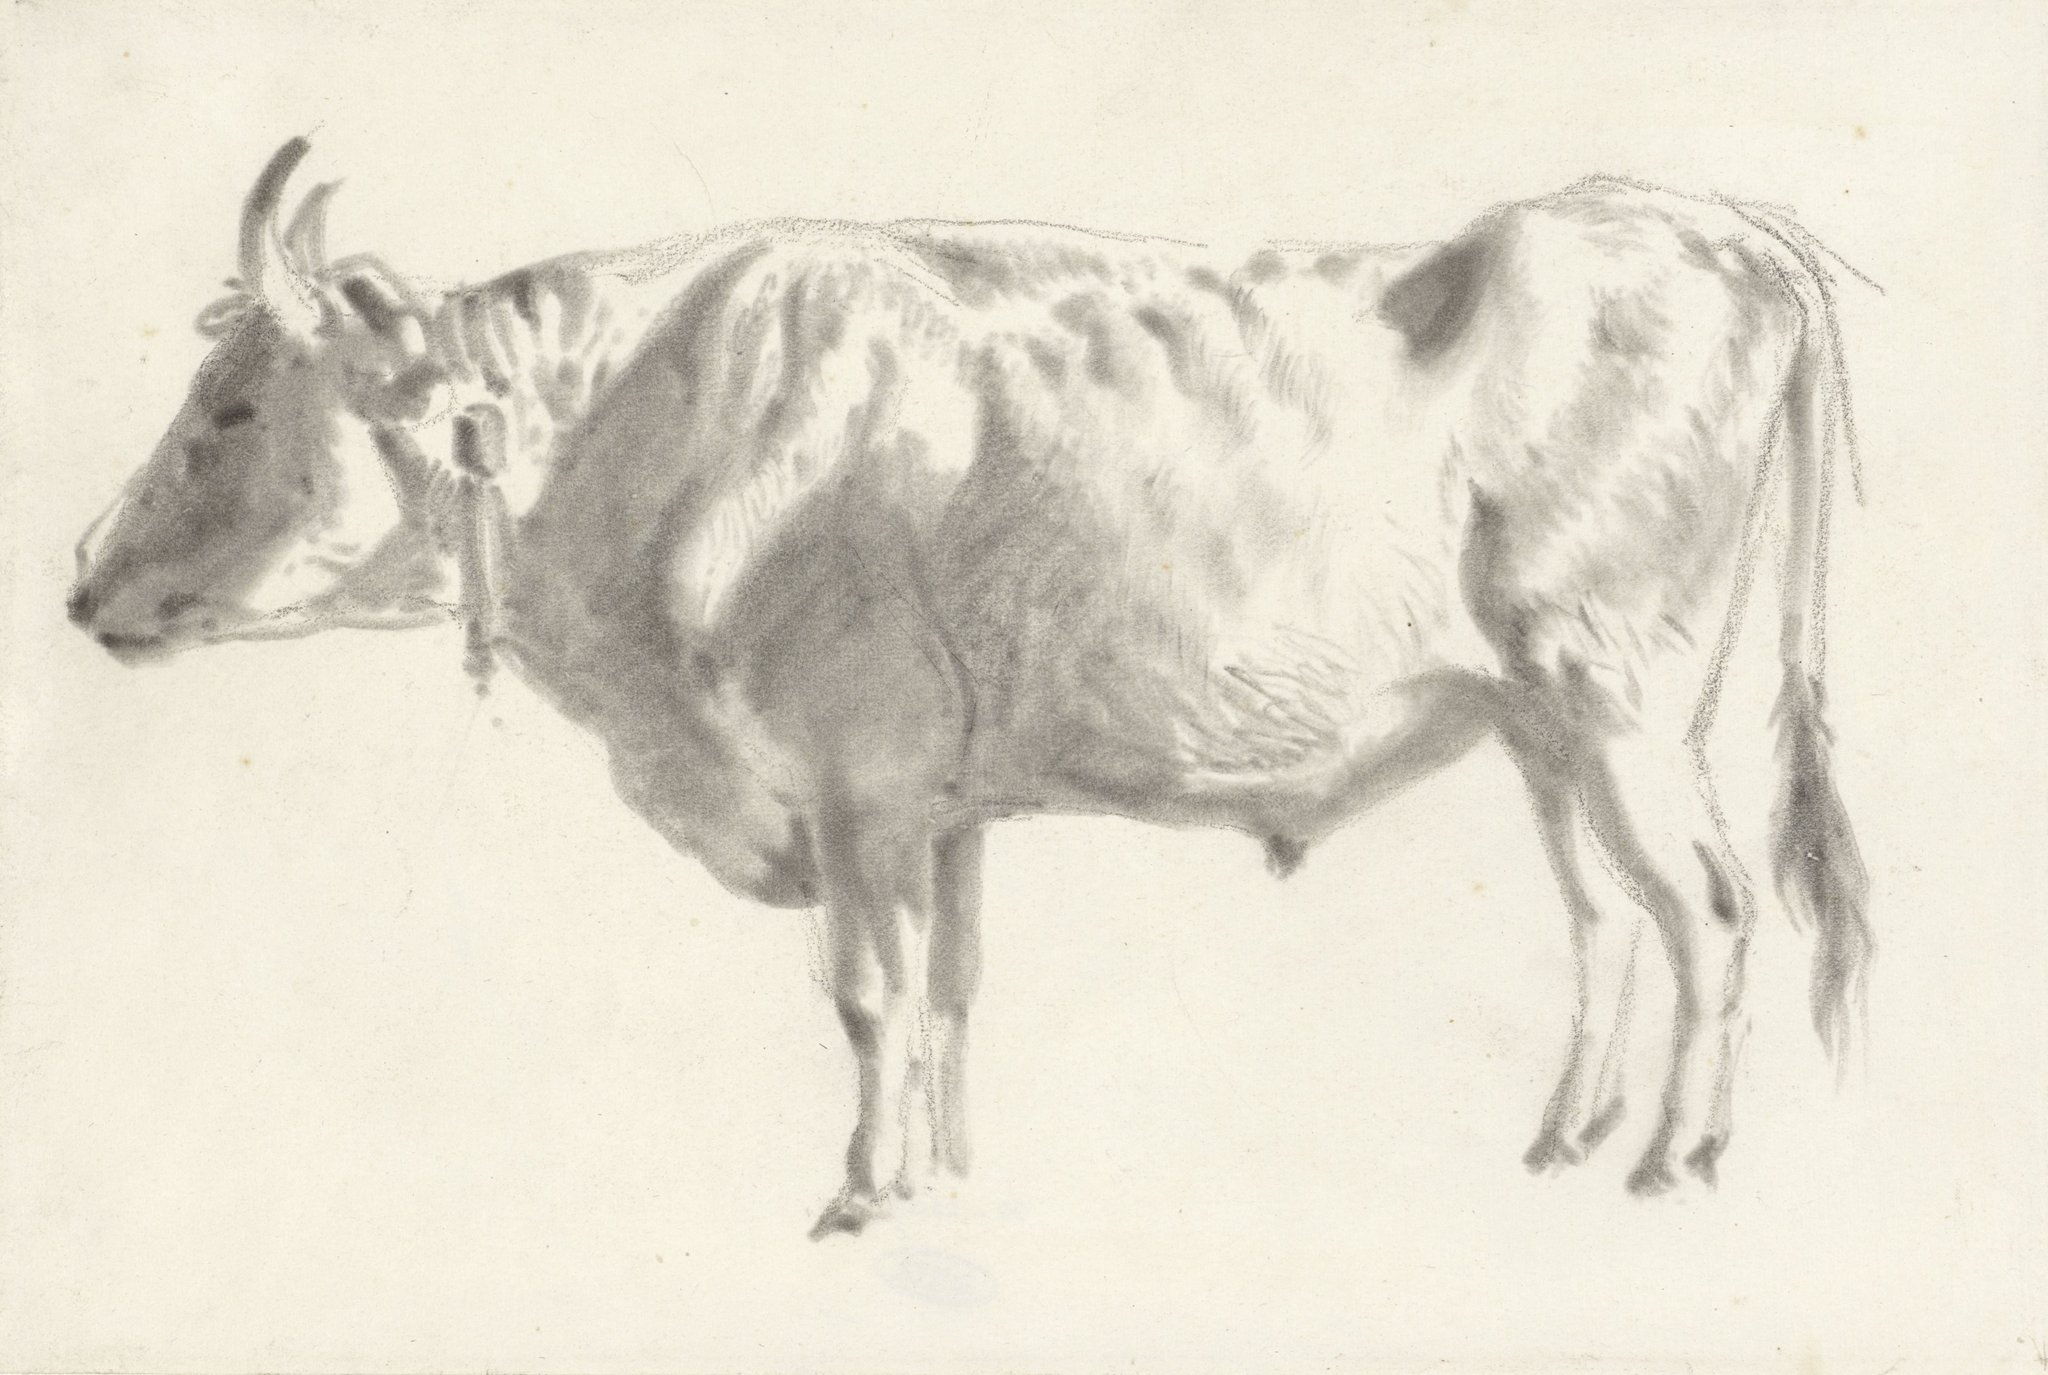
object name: drawing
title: Studie van een os, in profiel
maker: johan daniël koelman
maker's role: draughtsman, print maker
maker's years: 1831-1857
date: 1841-1857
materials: chalk, charcoal, paper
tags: ox